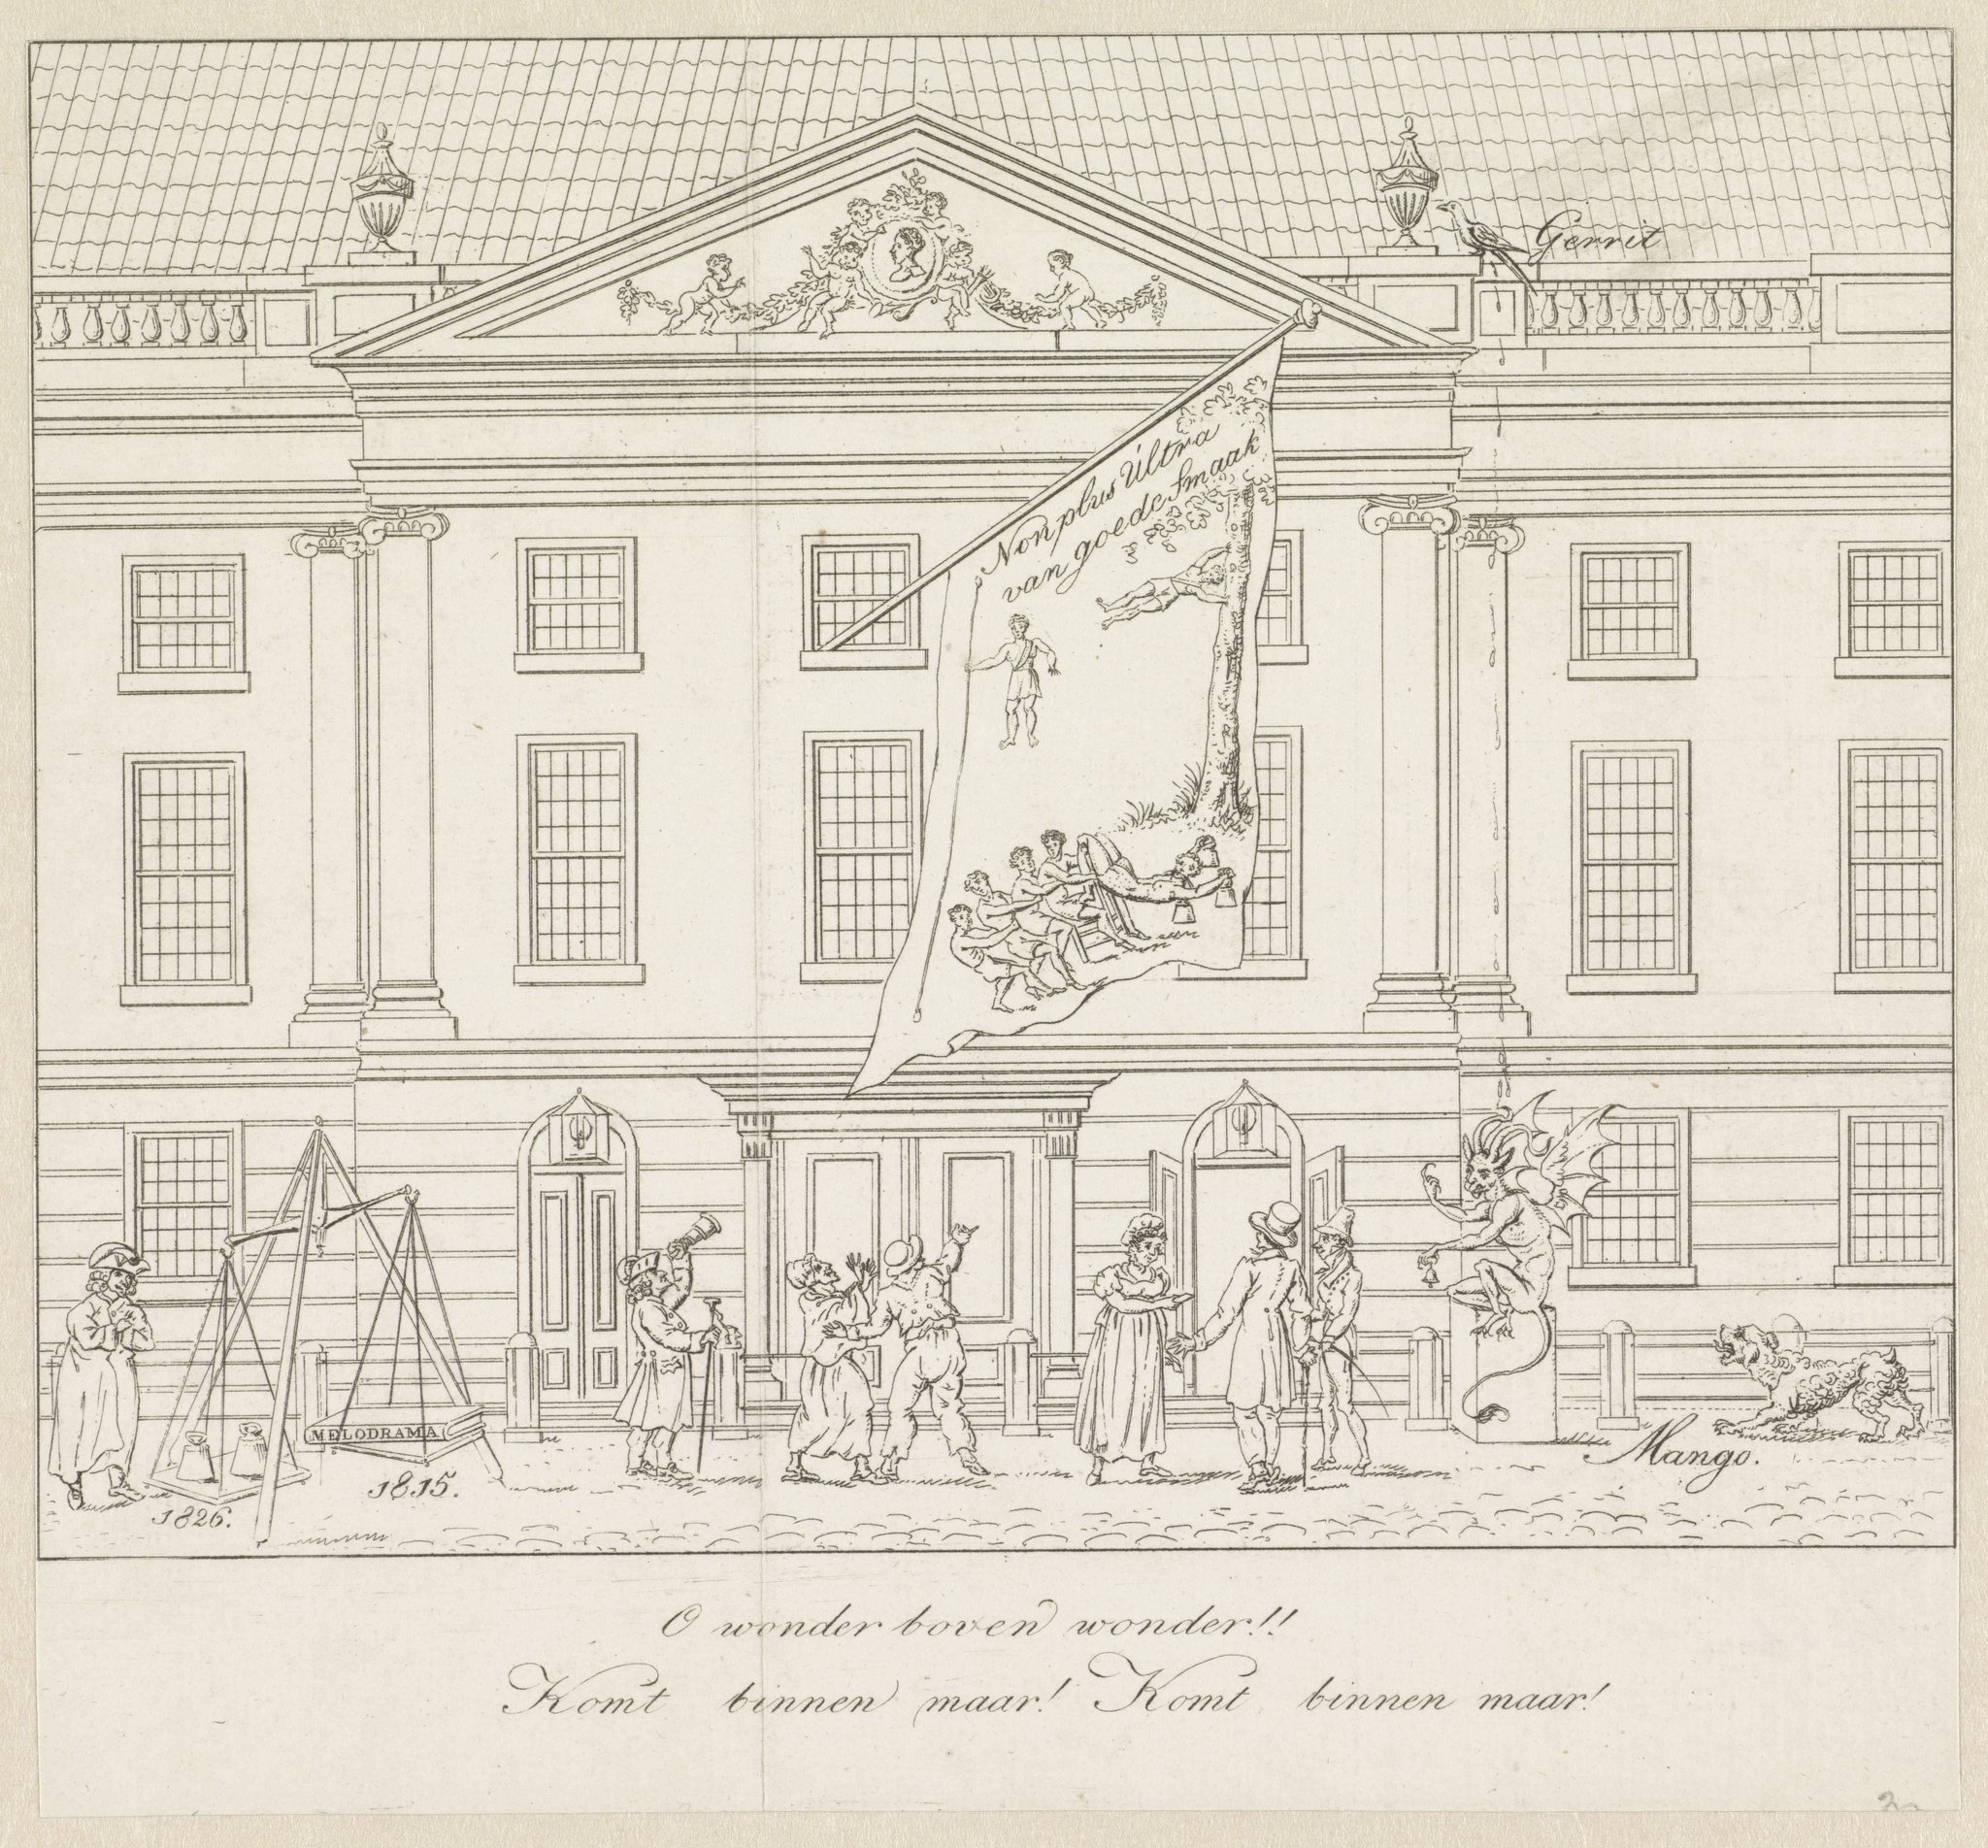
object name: cartoon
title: Spotprent op de wansmaak van voorstellingen in de schouwburg aan het Leidseplein te Amsterdam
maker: Anonymous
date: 1826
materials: paper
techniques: etching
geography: netherlands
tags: fighting contest (sport), theatre (building), the show; fair and circus performers, dogs (circus performance)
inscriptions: collector's mark: Lugt 2228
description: Spotprent op de wansmaak in de voorstellingen met acrobaten, gewichtheffers en circusdieren in de Stadsschouwburg te Amsterdam, 1826. Voor de gevel van de schouwburg bevinden zich een aantal figuren. Links wordt op een weegschaal '1826' gewogen tegen 'Melodrama' van 1815. Een man met een verrekijker en twee sloebers kijken naar het grote vaandel dat aan de gevel hangt. Hierop vertonen worstelaars hun kunsten, met opschrift 'Non plus Ultra van goede smaak'. Voor een openstaande deur praat een vrouw met een man, hierbij staat een figuur met bokkenpoten (de duivel), rechts hiervan zit een andere duivel op een zuil en blaft de gedresseerde hond Mango. Vanaf de daklijst schijt de ekster Gerrit op de kop van de duivel. Met tweeregelig onderschrift.